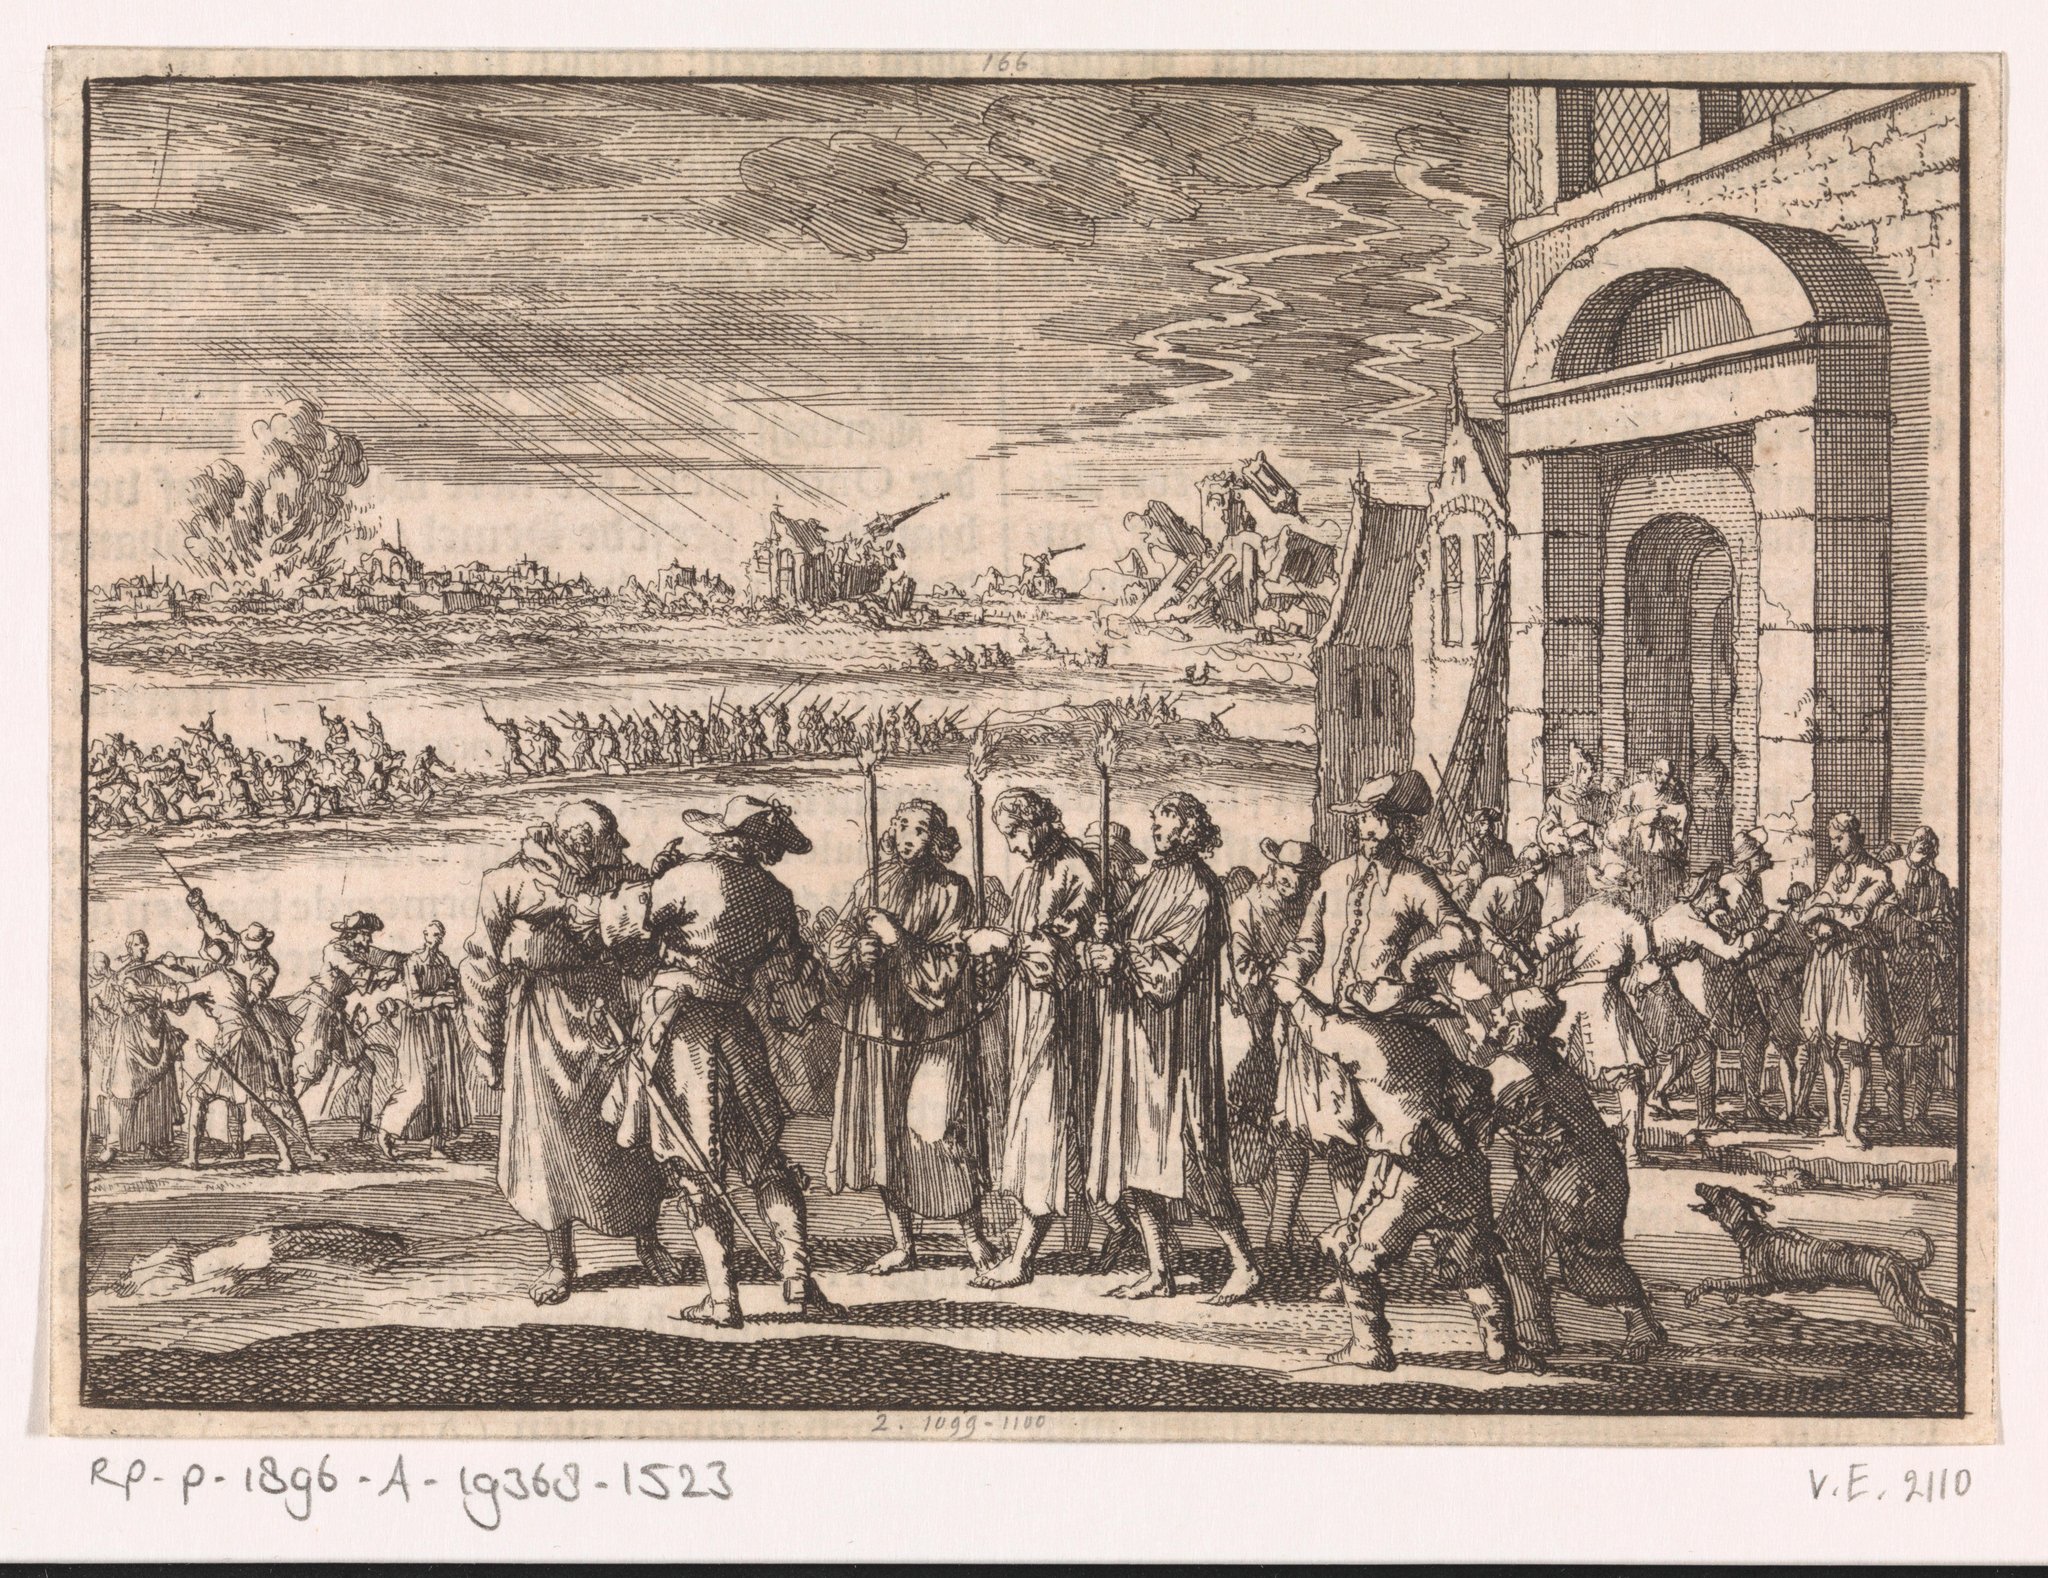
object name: book illustration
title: Vervolging van Protestanten in Frankrijk, 1672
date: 1698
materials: paper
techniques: etching, letterpress printing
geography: leiden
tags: persecution of believers, france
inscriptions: collector's mark: Lugt 2228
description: Illustratie uit: Gottfried, Johann Ludwig. Historische kronyck; vervattende een (...) beschrijvingh der aldergedenckwaerdigste geschiedenissen des weerelds, van den aenvangh der scheppingh tot (...) 1576 (2 delen). Leiden: Pieter van der Aa, 1698, dl. II, p. 1099.